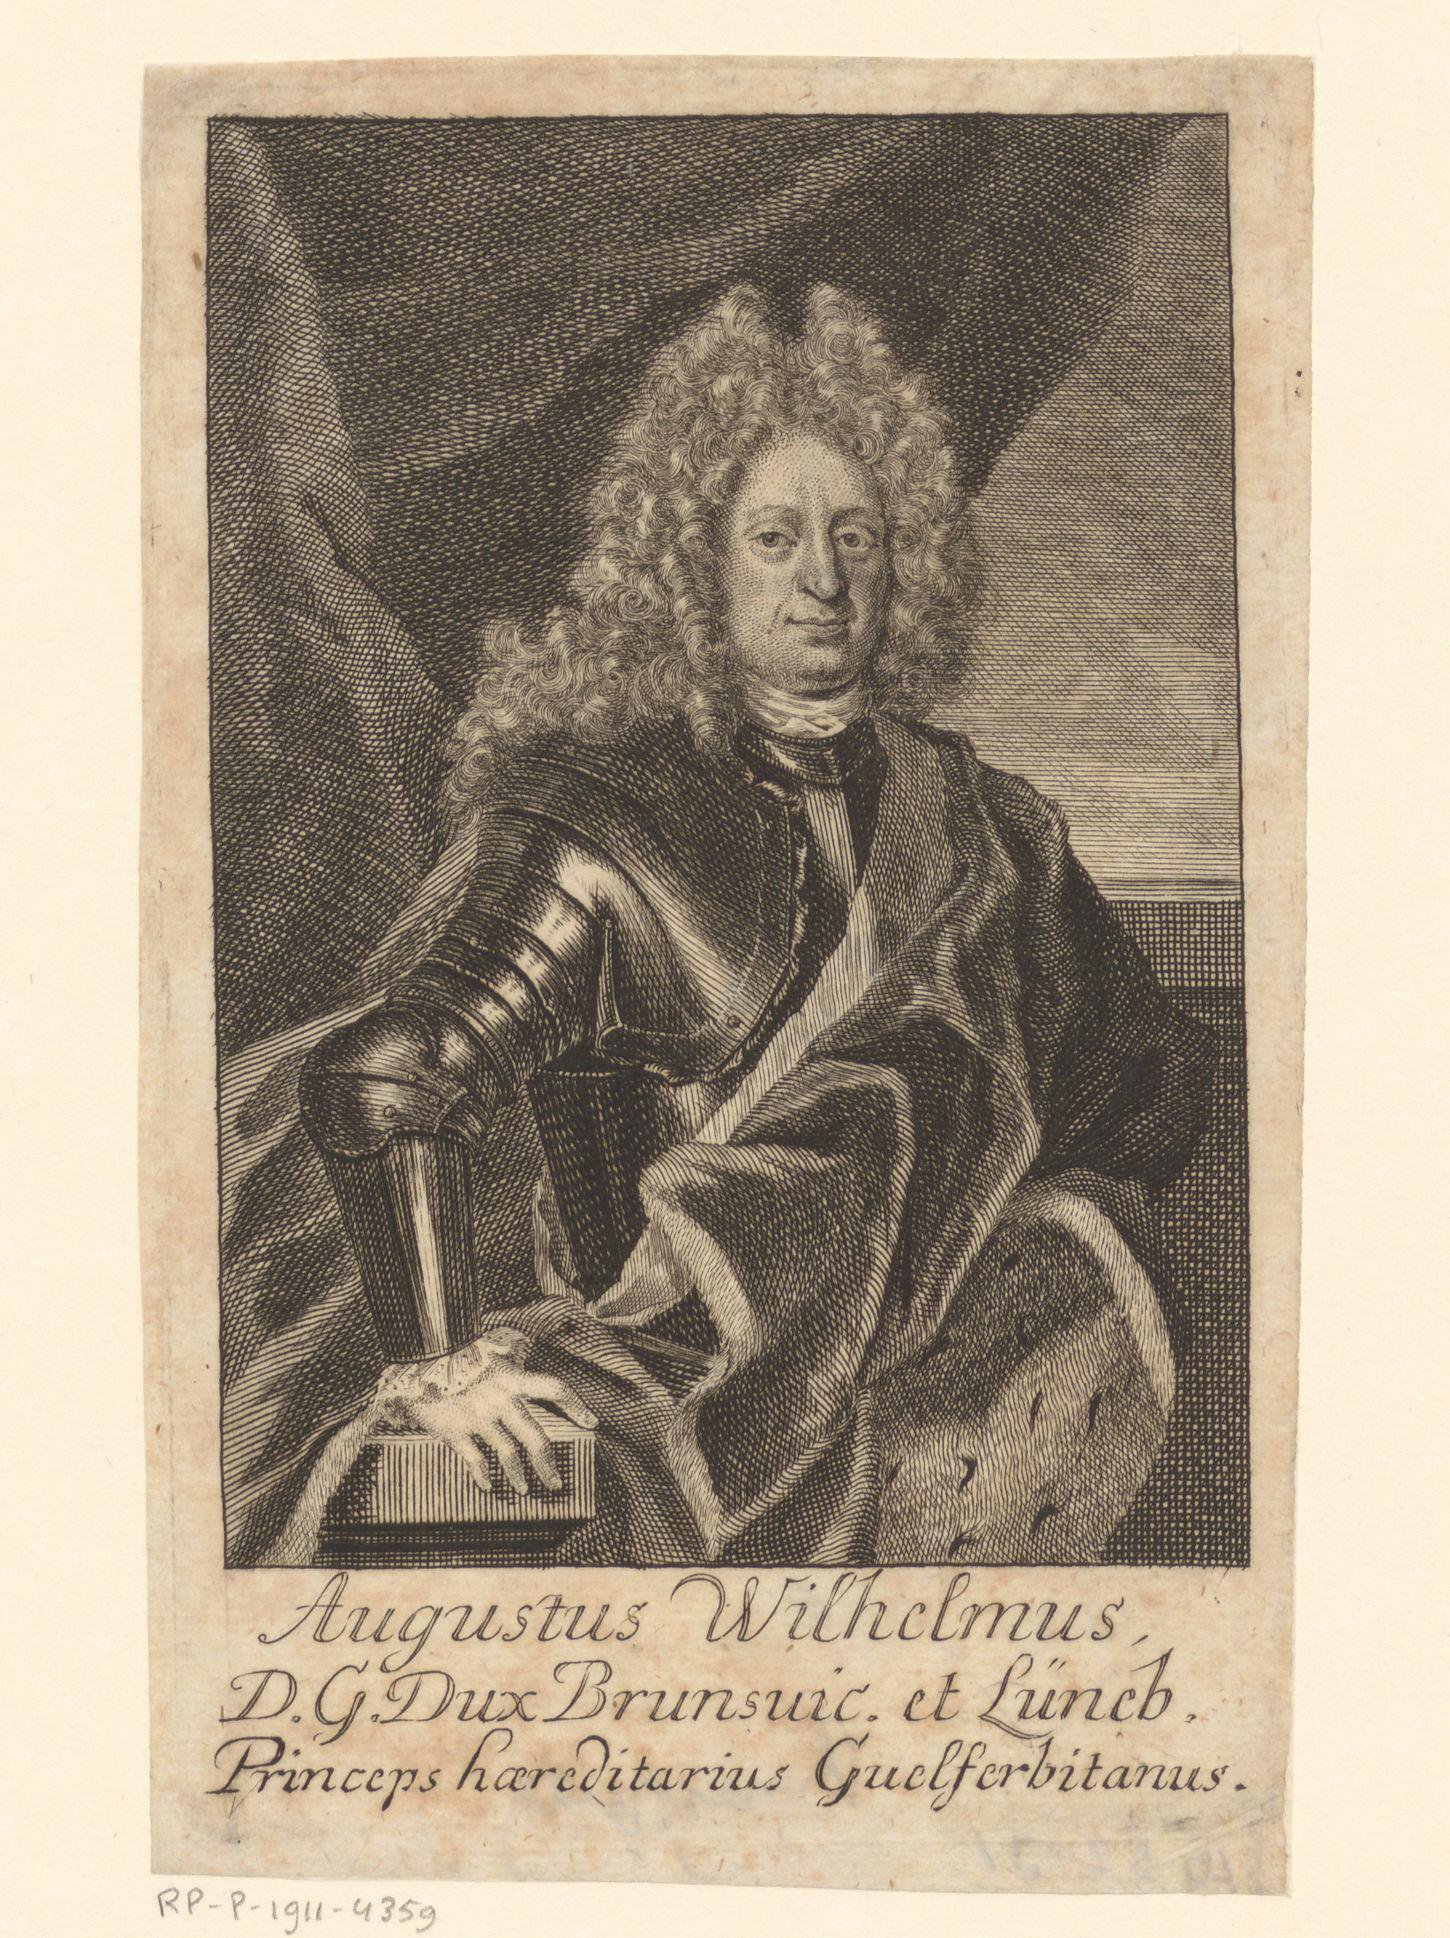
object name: print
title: Portret van August Wilhelm von Braunschweig-Lüneburg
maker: martin bernigeroth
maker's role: print maker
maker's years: 1670-1733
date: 1711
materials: paper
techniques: engraving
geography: leipzig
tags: armour, historical persons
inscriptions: collector's mark: Lugt 2228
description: Prent gebruikt voor: Die Europäische Fama, welche den gegenwärtigen Zustand der vornehmsten Höfe entdecket. dl. 122. Leipzig: Gleditsch, 1711.